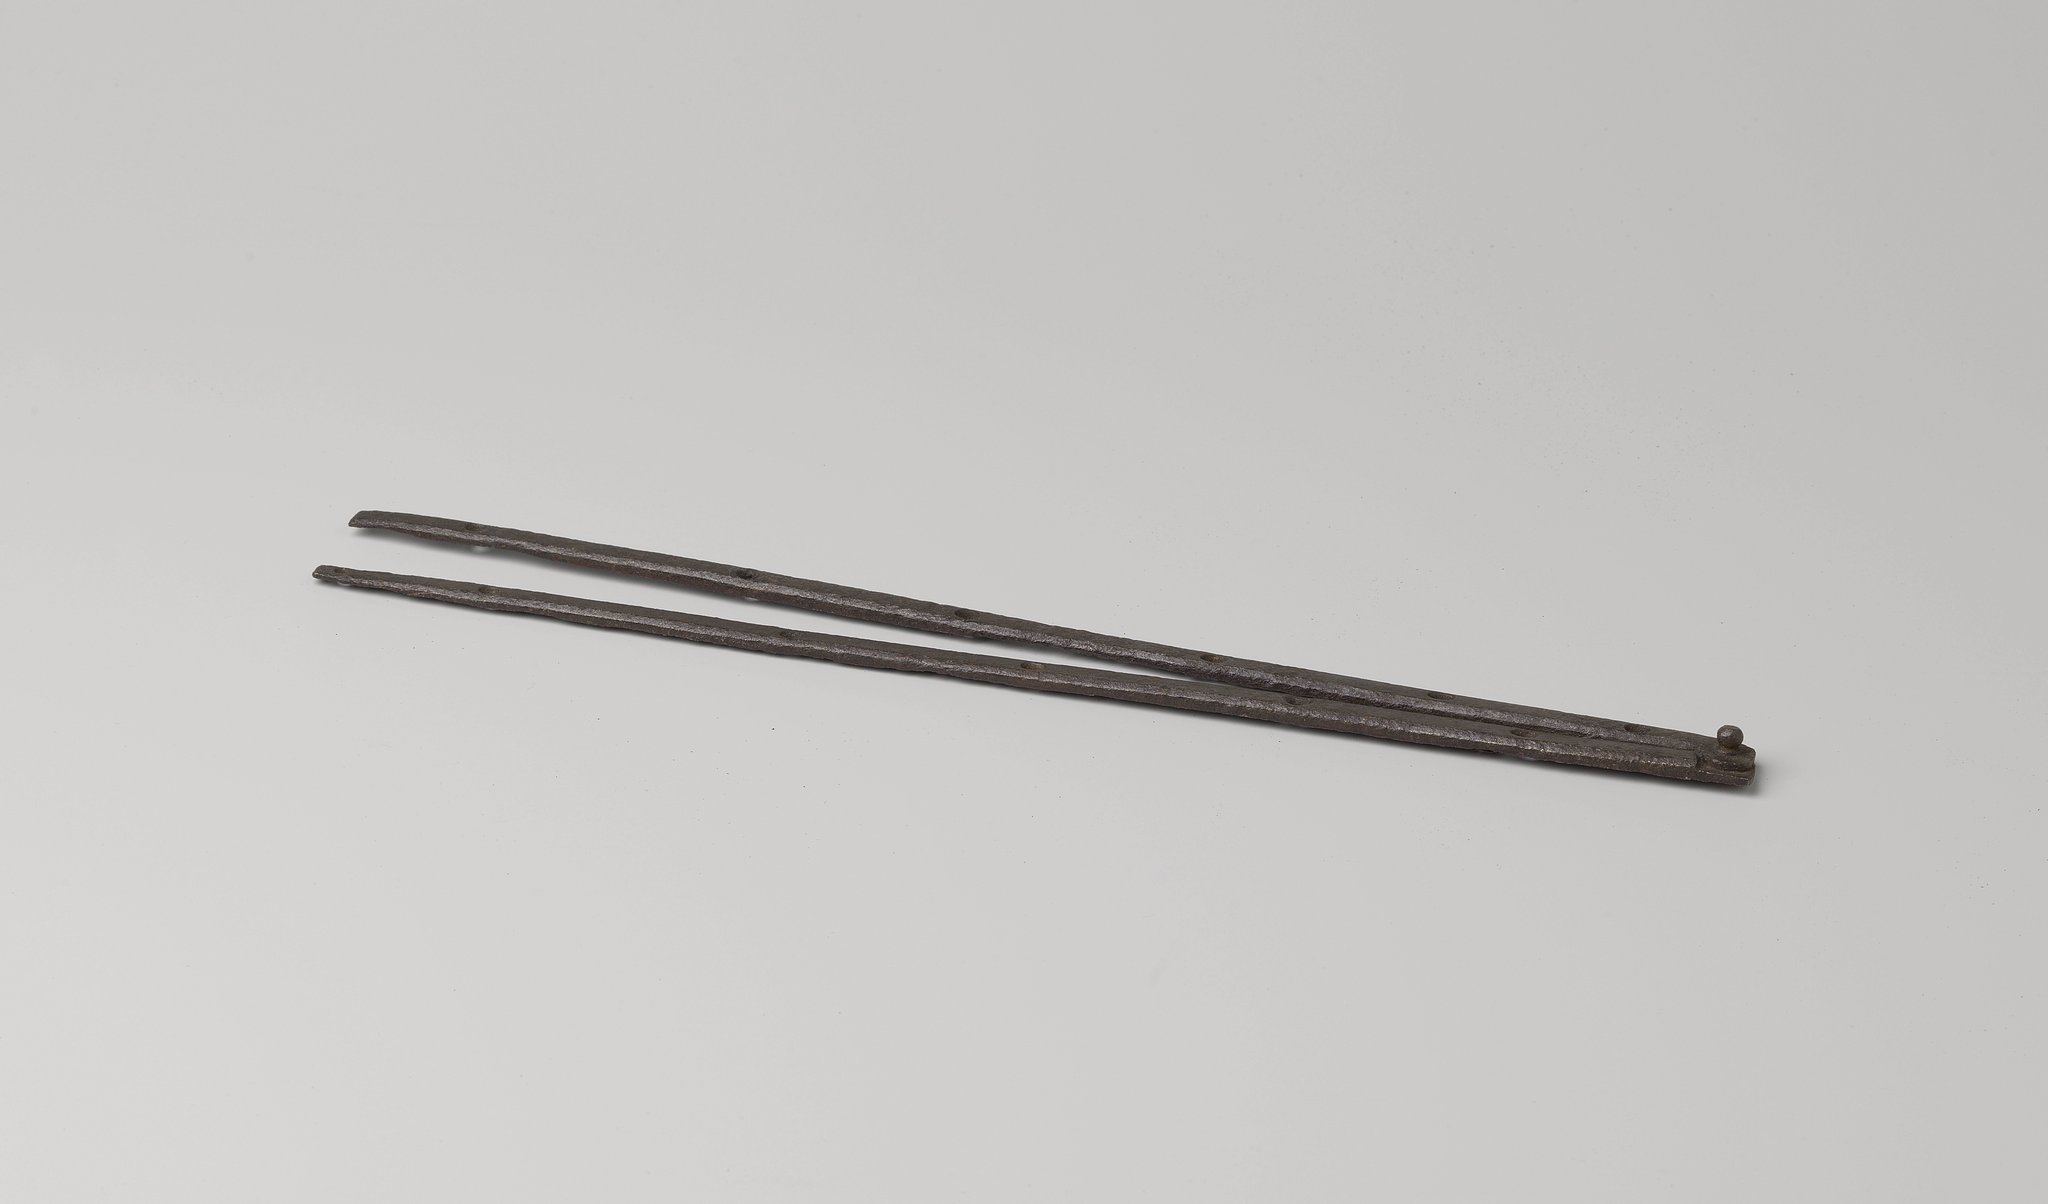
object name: scharnier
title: Kastscharnier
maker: Anonymous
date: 1590-1596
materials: iron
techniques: forging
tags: willem barendsz., amsterdam, jacob van heemskerck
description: Scharnier vermoedelijk een openhouder. Heeft vermoedelijk deel uitgemaakt van een kist.